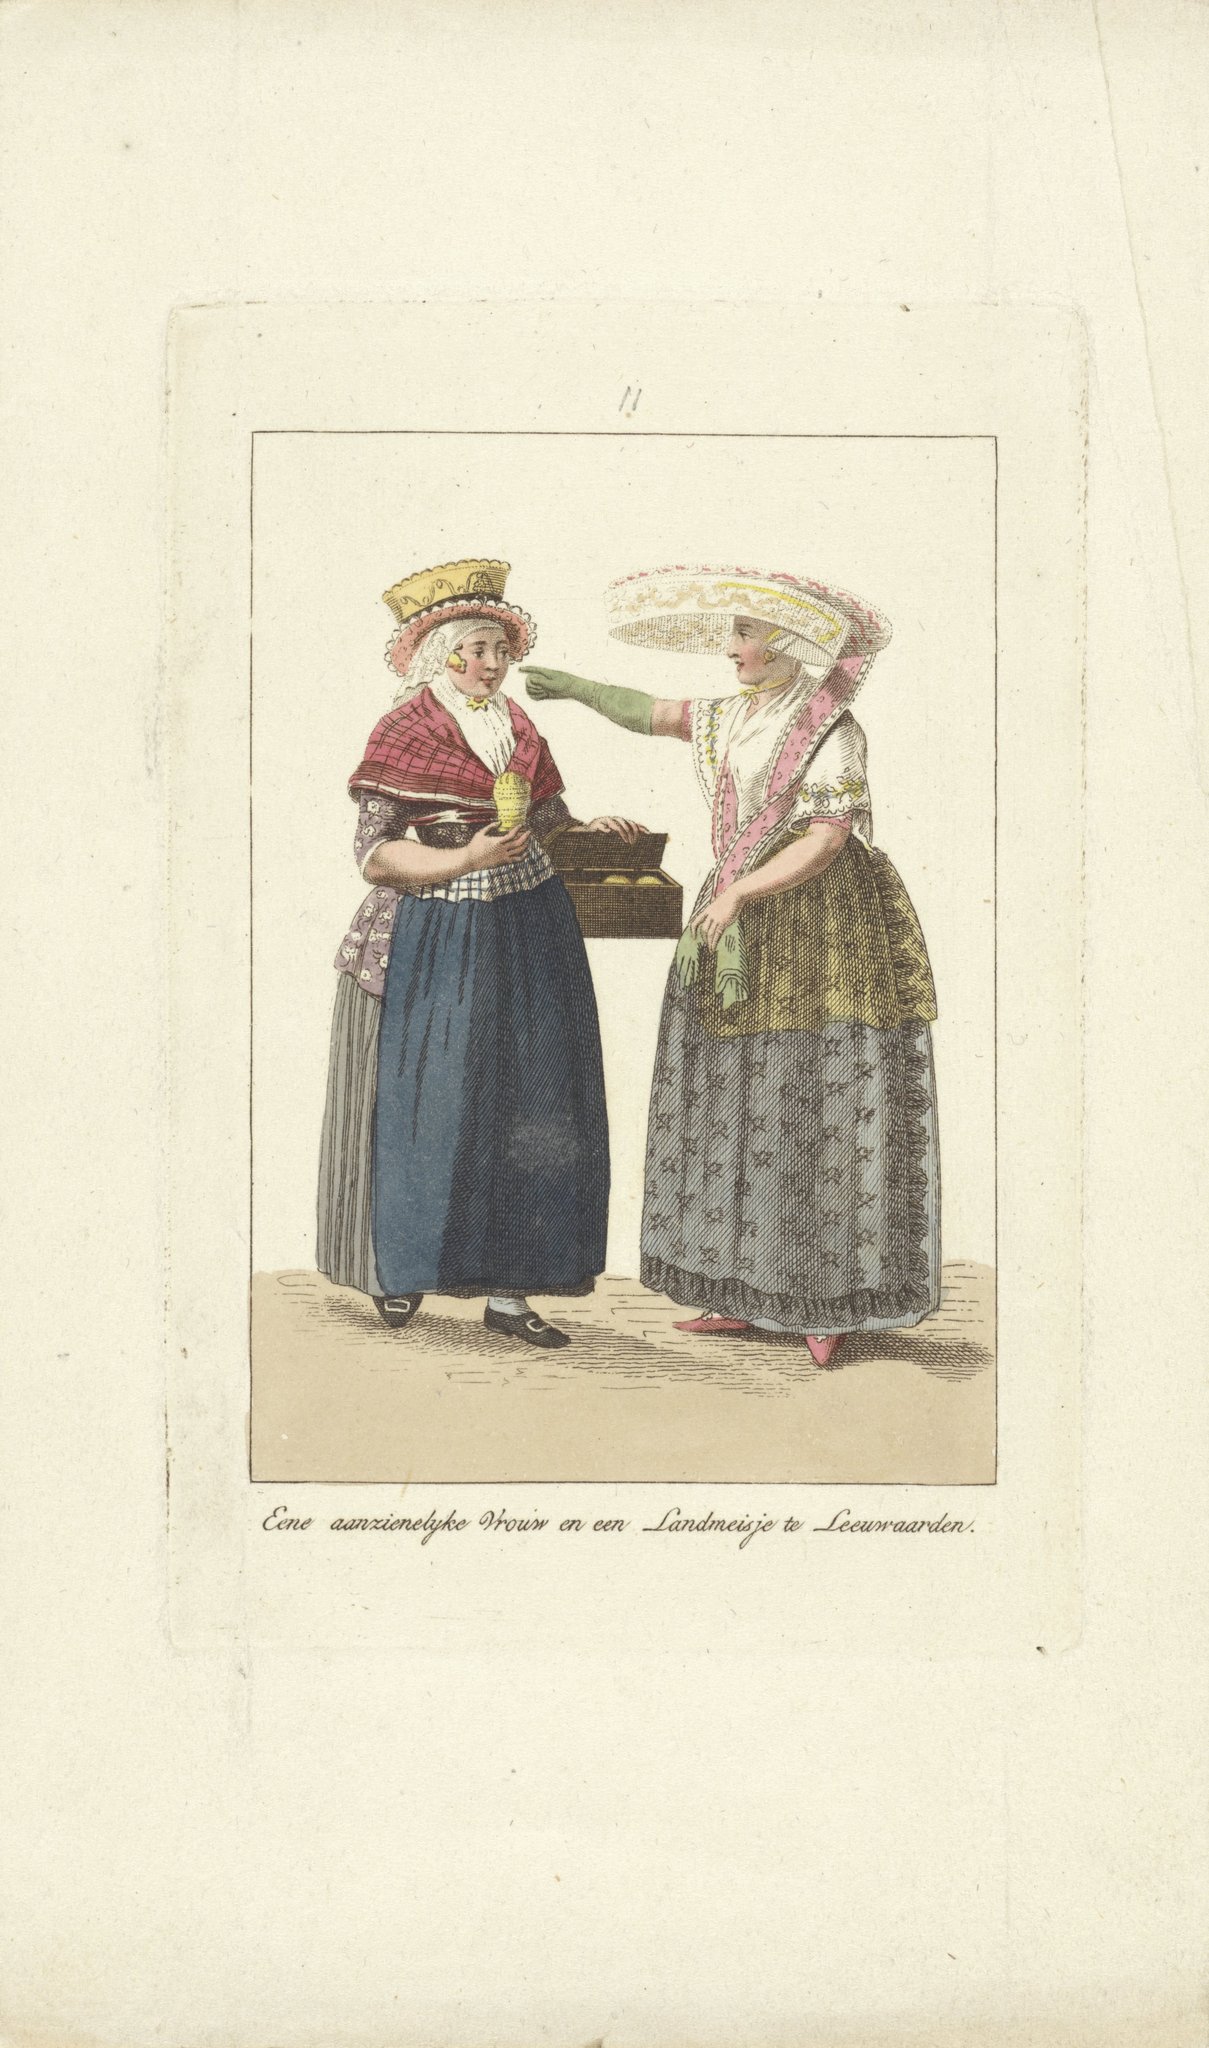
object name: print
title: Boterverkoopster en klant in klederdracht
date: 1806-1812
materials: paper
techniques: etching, hand coloring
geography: amsterdam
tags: butter, clothes, costume (+ women's clothes), street-trader, folk costume, regional costume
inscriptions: collector's mark: Lugt 2228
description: De boterverkoopster houdt een bakje boter in de hand. Haar klant, een dame met breed gerande muts op het hoofd, wijst naar haar huis waar de boter afgeleverd moet worden.